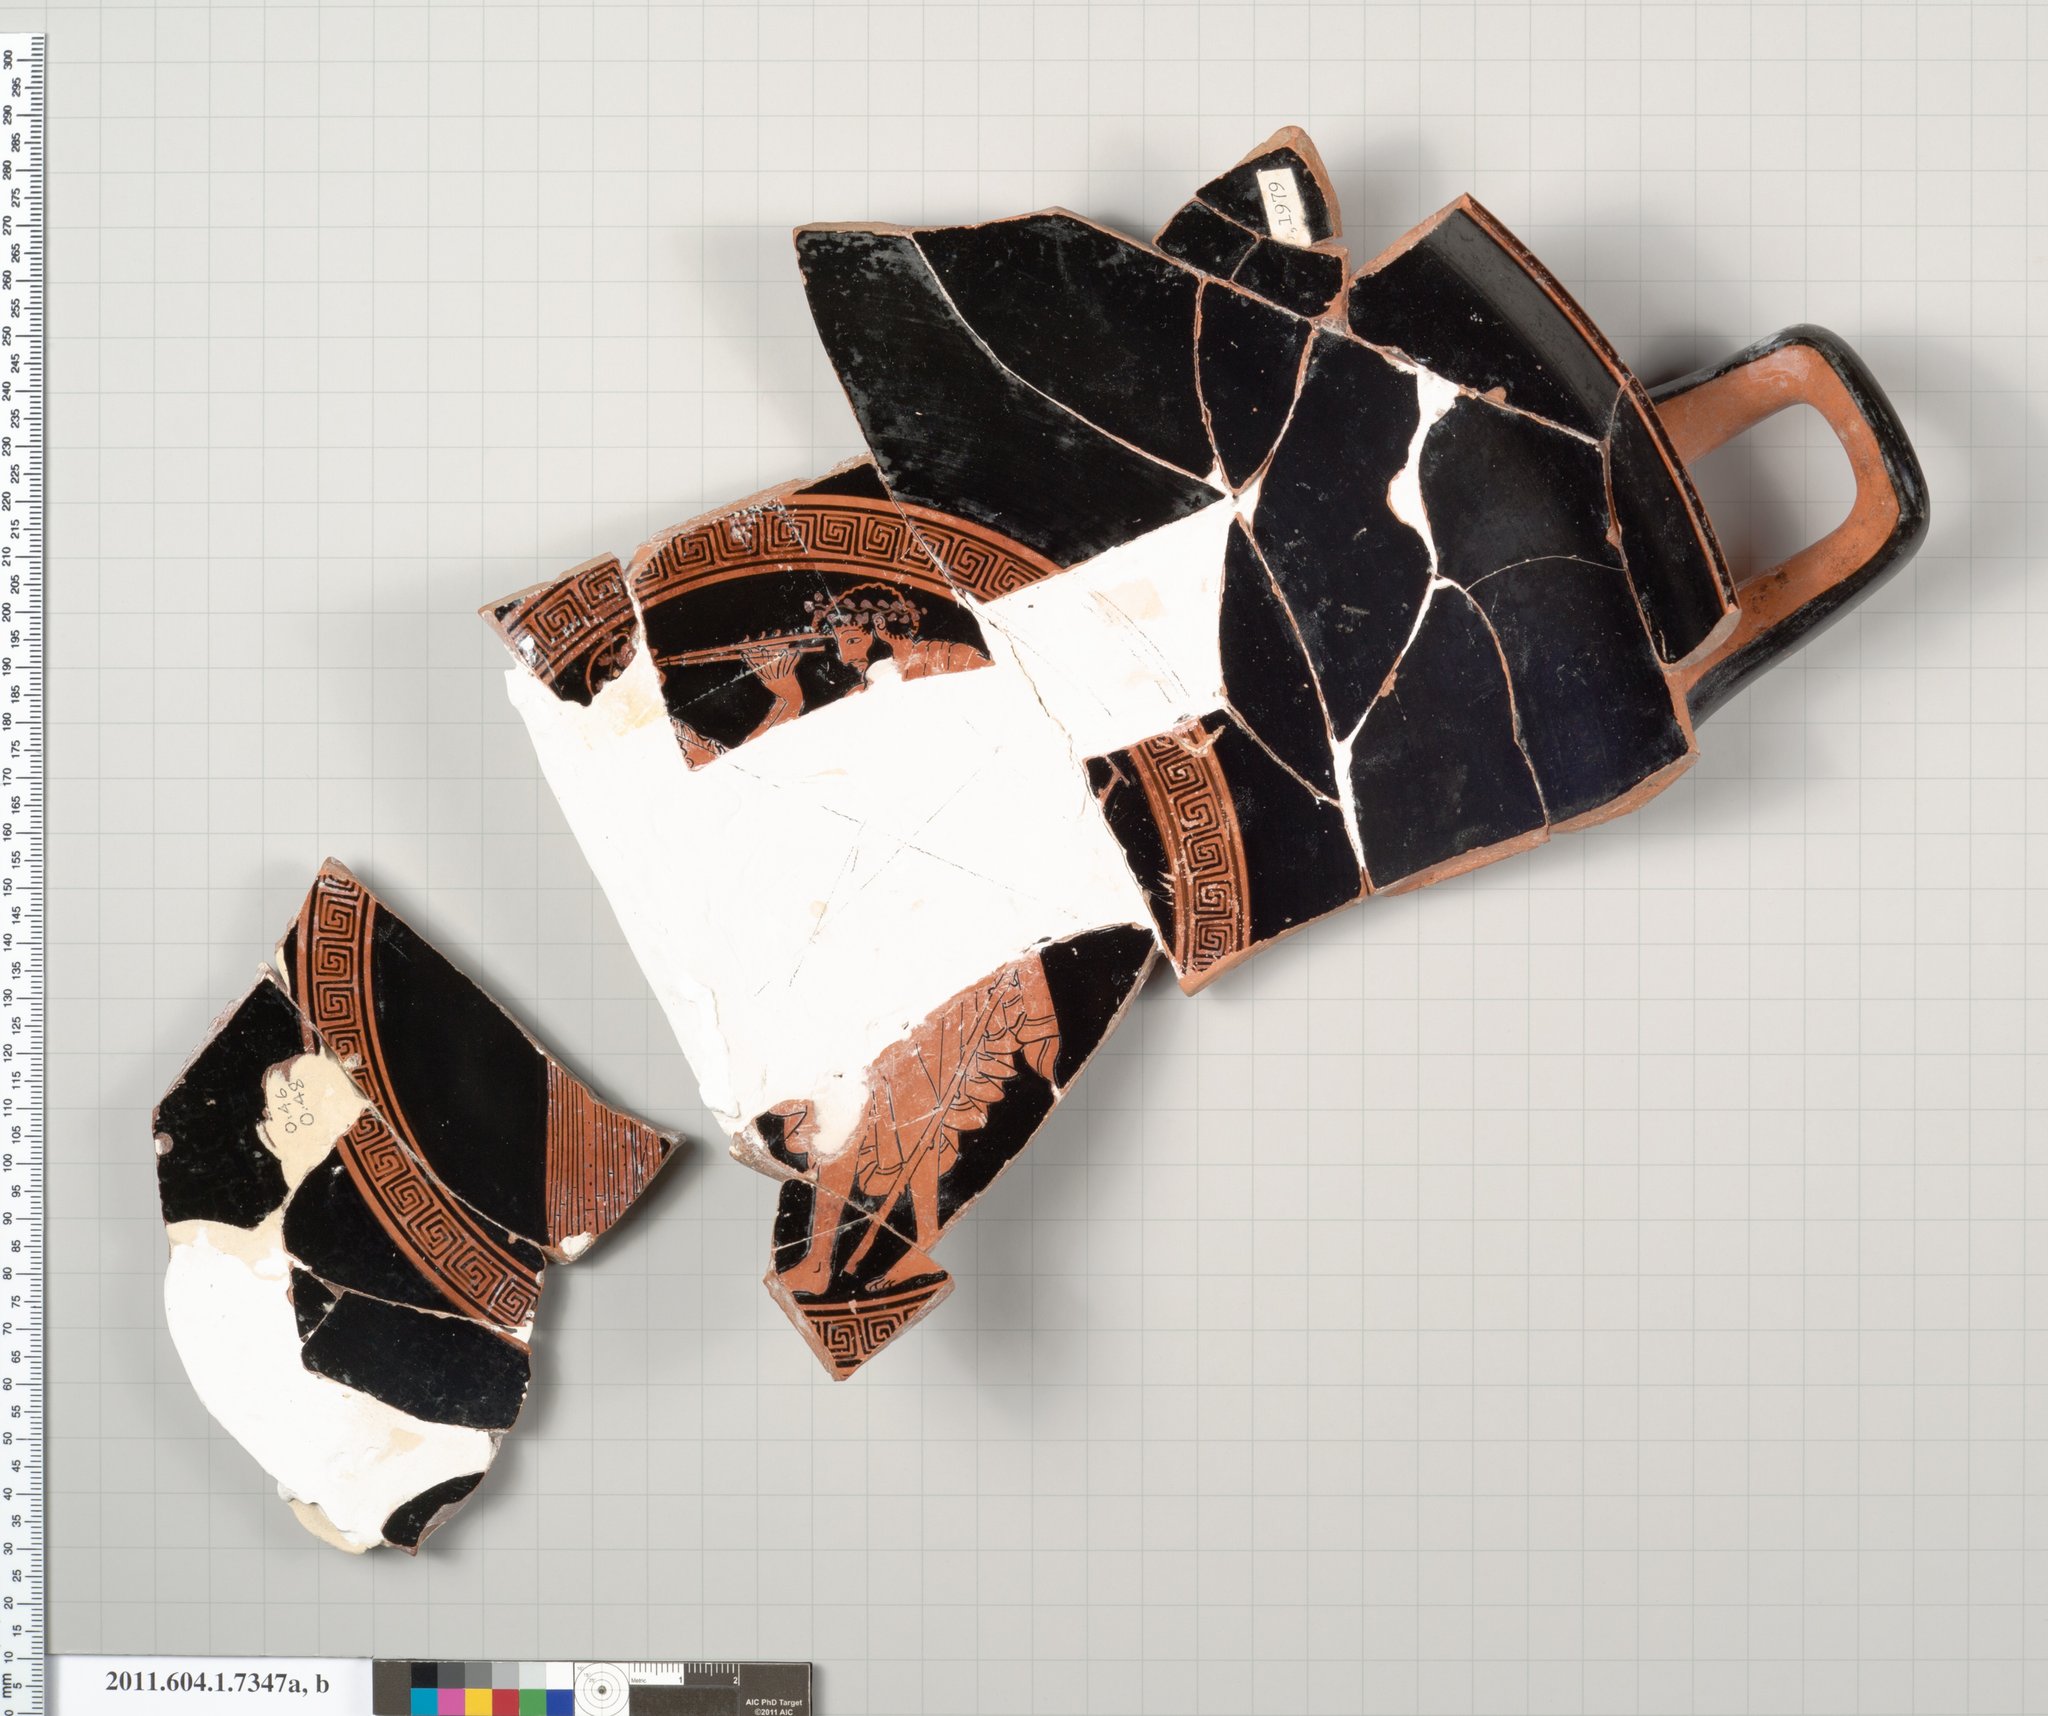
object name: kylix fragment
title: Terracotta fragments of a kylix (drinking cup)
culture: greek, attic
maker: makron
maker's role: artist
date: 500-480 BCE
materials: terracotta